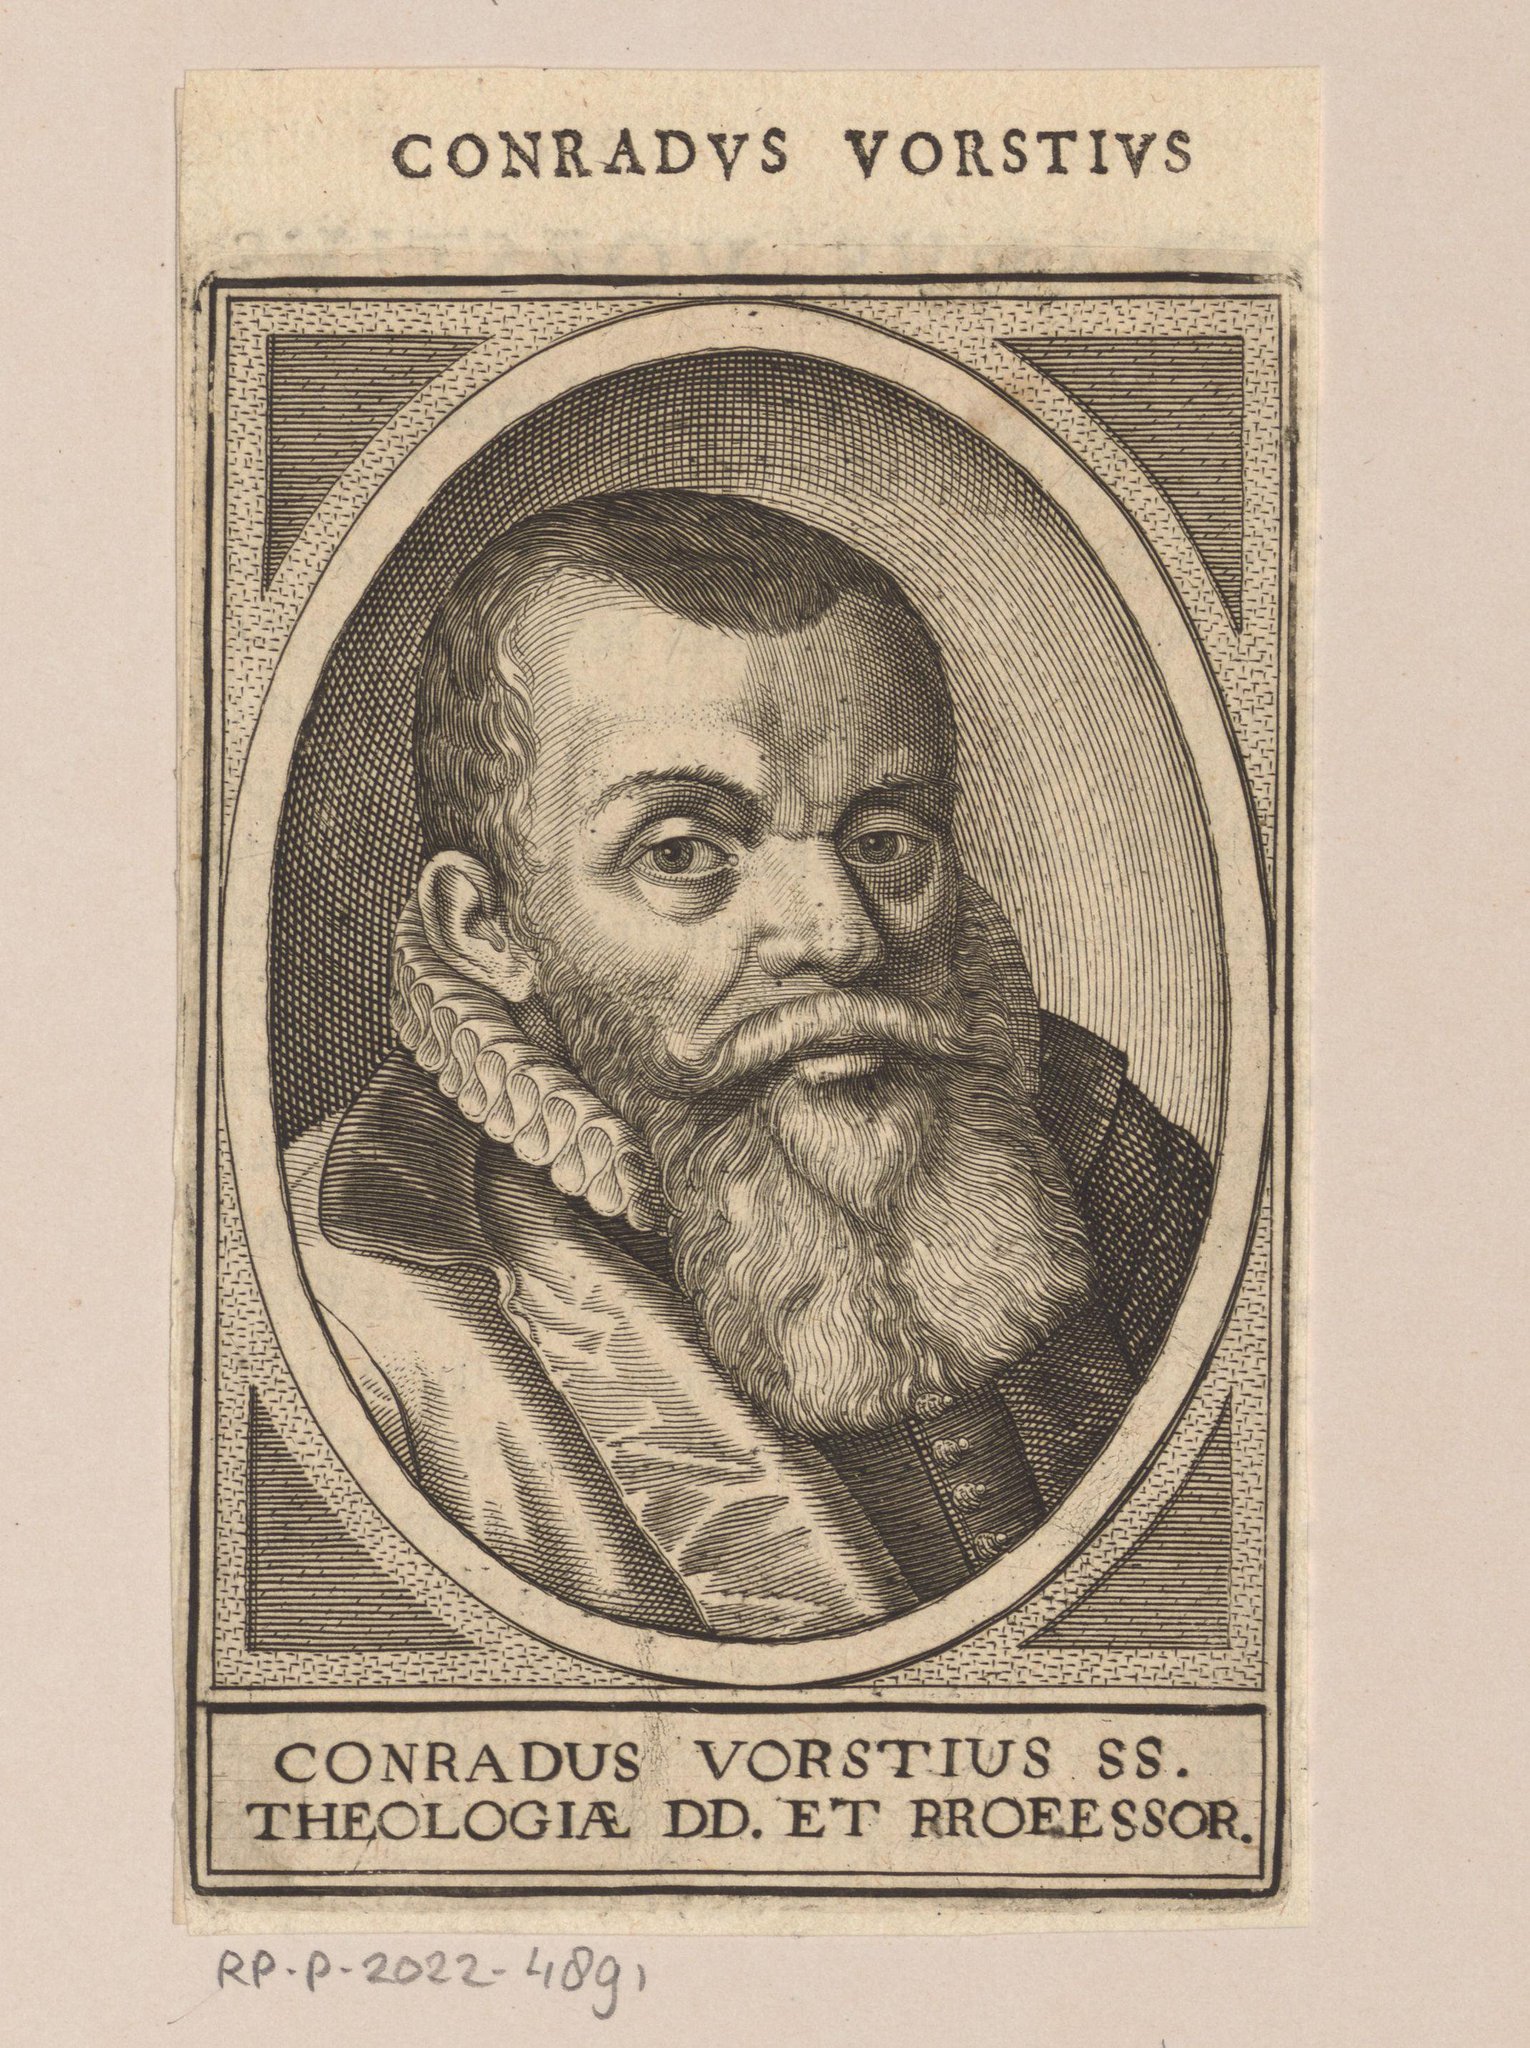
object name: print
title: Portret van Conradus Vorstius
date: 1614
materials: paper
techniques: engraving, letterpress printing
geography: leiden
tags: theologian, historical persons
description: Prent uit: Illustrium Hollandiae & Westfrisiae ordinum alma academia Leidensis. Leiden: Jacob Marcus en Joost van Colster, 1614.